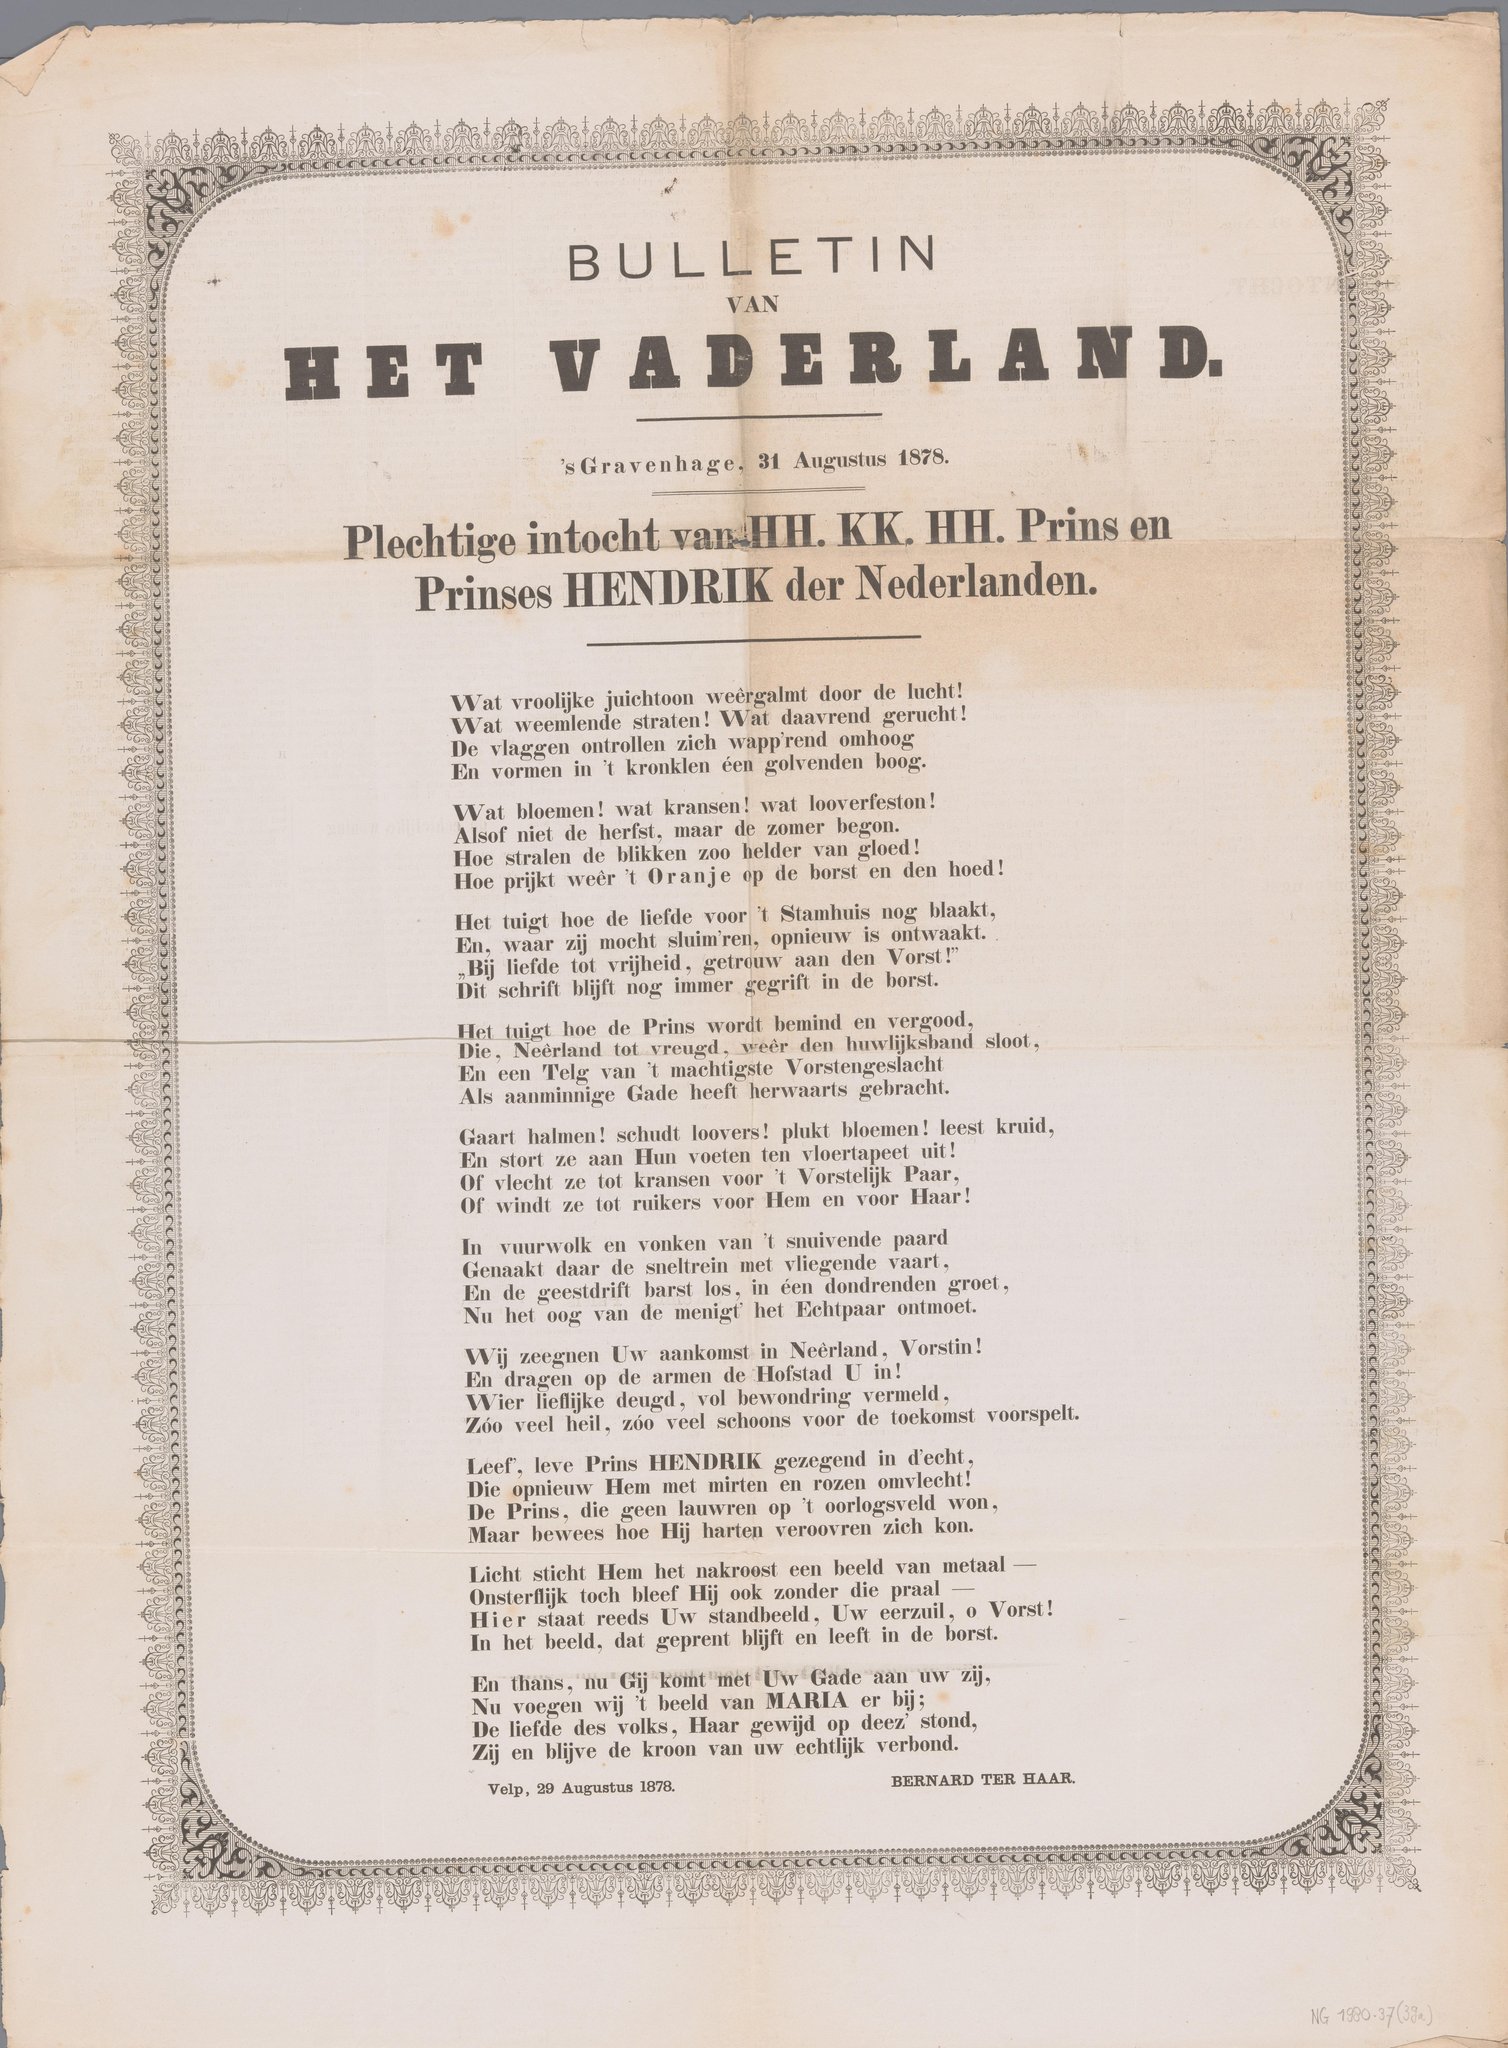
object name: newspaper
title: Bulletin van Het Vaderland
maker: bernard ter haar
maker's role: predikant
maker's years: 1806-1880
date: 1878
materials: paper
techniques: printing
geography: the hague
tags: hendrik (prins der nederlanden), netherlands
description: Krantebijvoegsel aan beide zijden bedrukt (1 blad) voorzijde gedicht, 10 strofen van elk 4 regels in versierd kader, achterzijde verslag van de intocht van prins Hendrik en zijn vrouw.